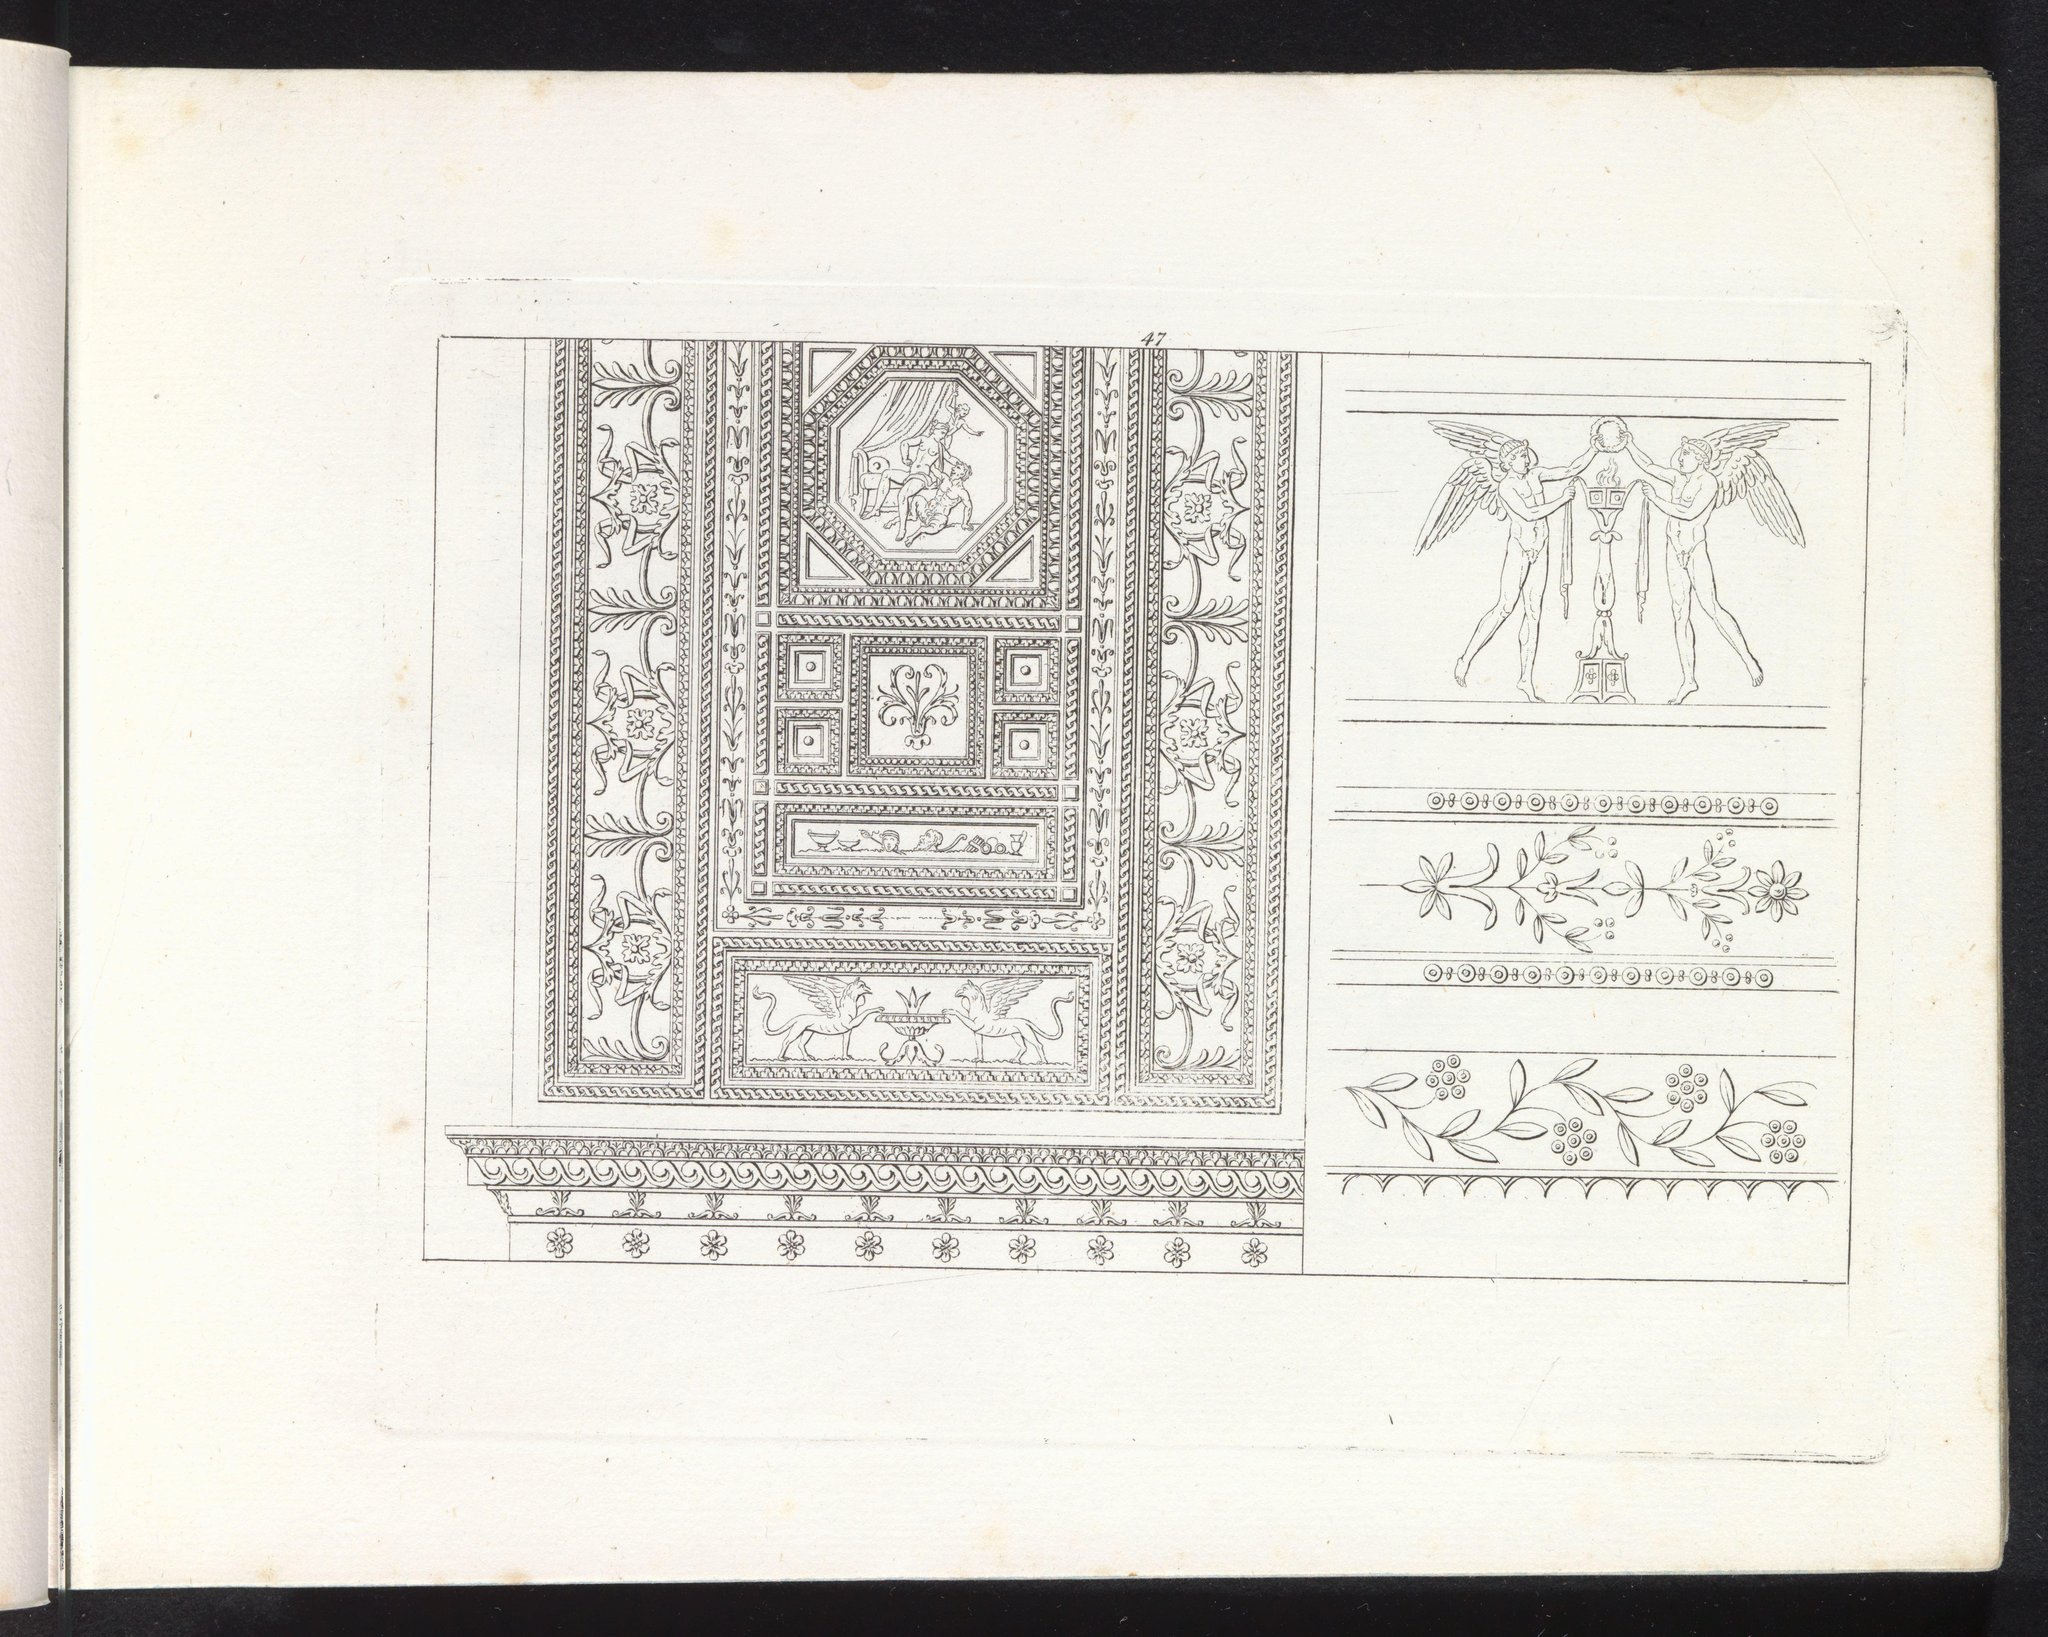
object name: ornament print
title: Invenzioni diverse di mobili ed utensili sacri e profani per usi comuni della vita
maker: pietro ruga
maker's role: print maker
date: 1817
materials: paper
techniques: etching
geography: italy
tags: ornaments ~ art, panelling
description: Prent maakt deel uit van een reeks van 100 prenten (+ titelprent) met ontwerpen voor religieuze en profane voorwerpen.